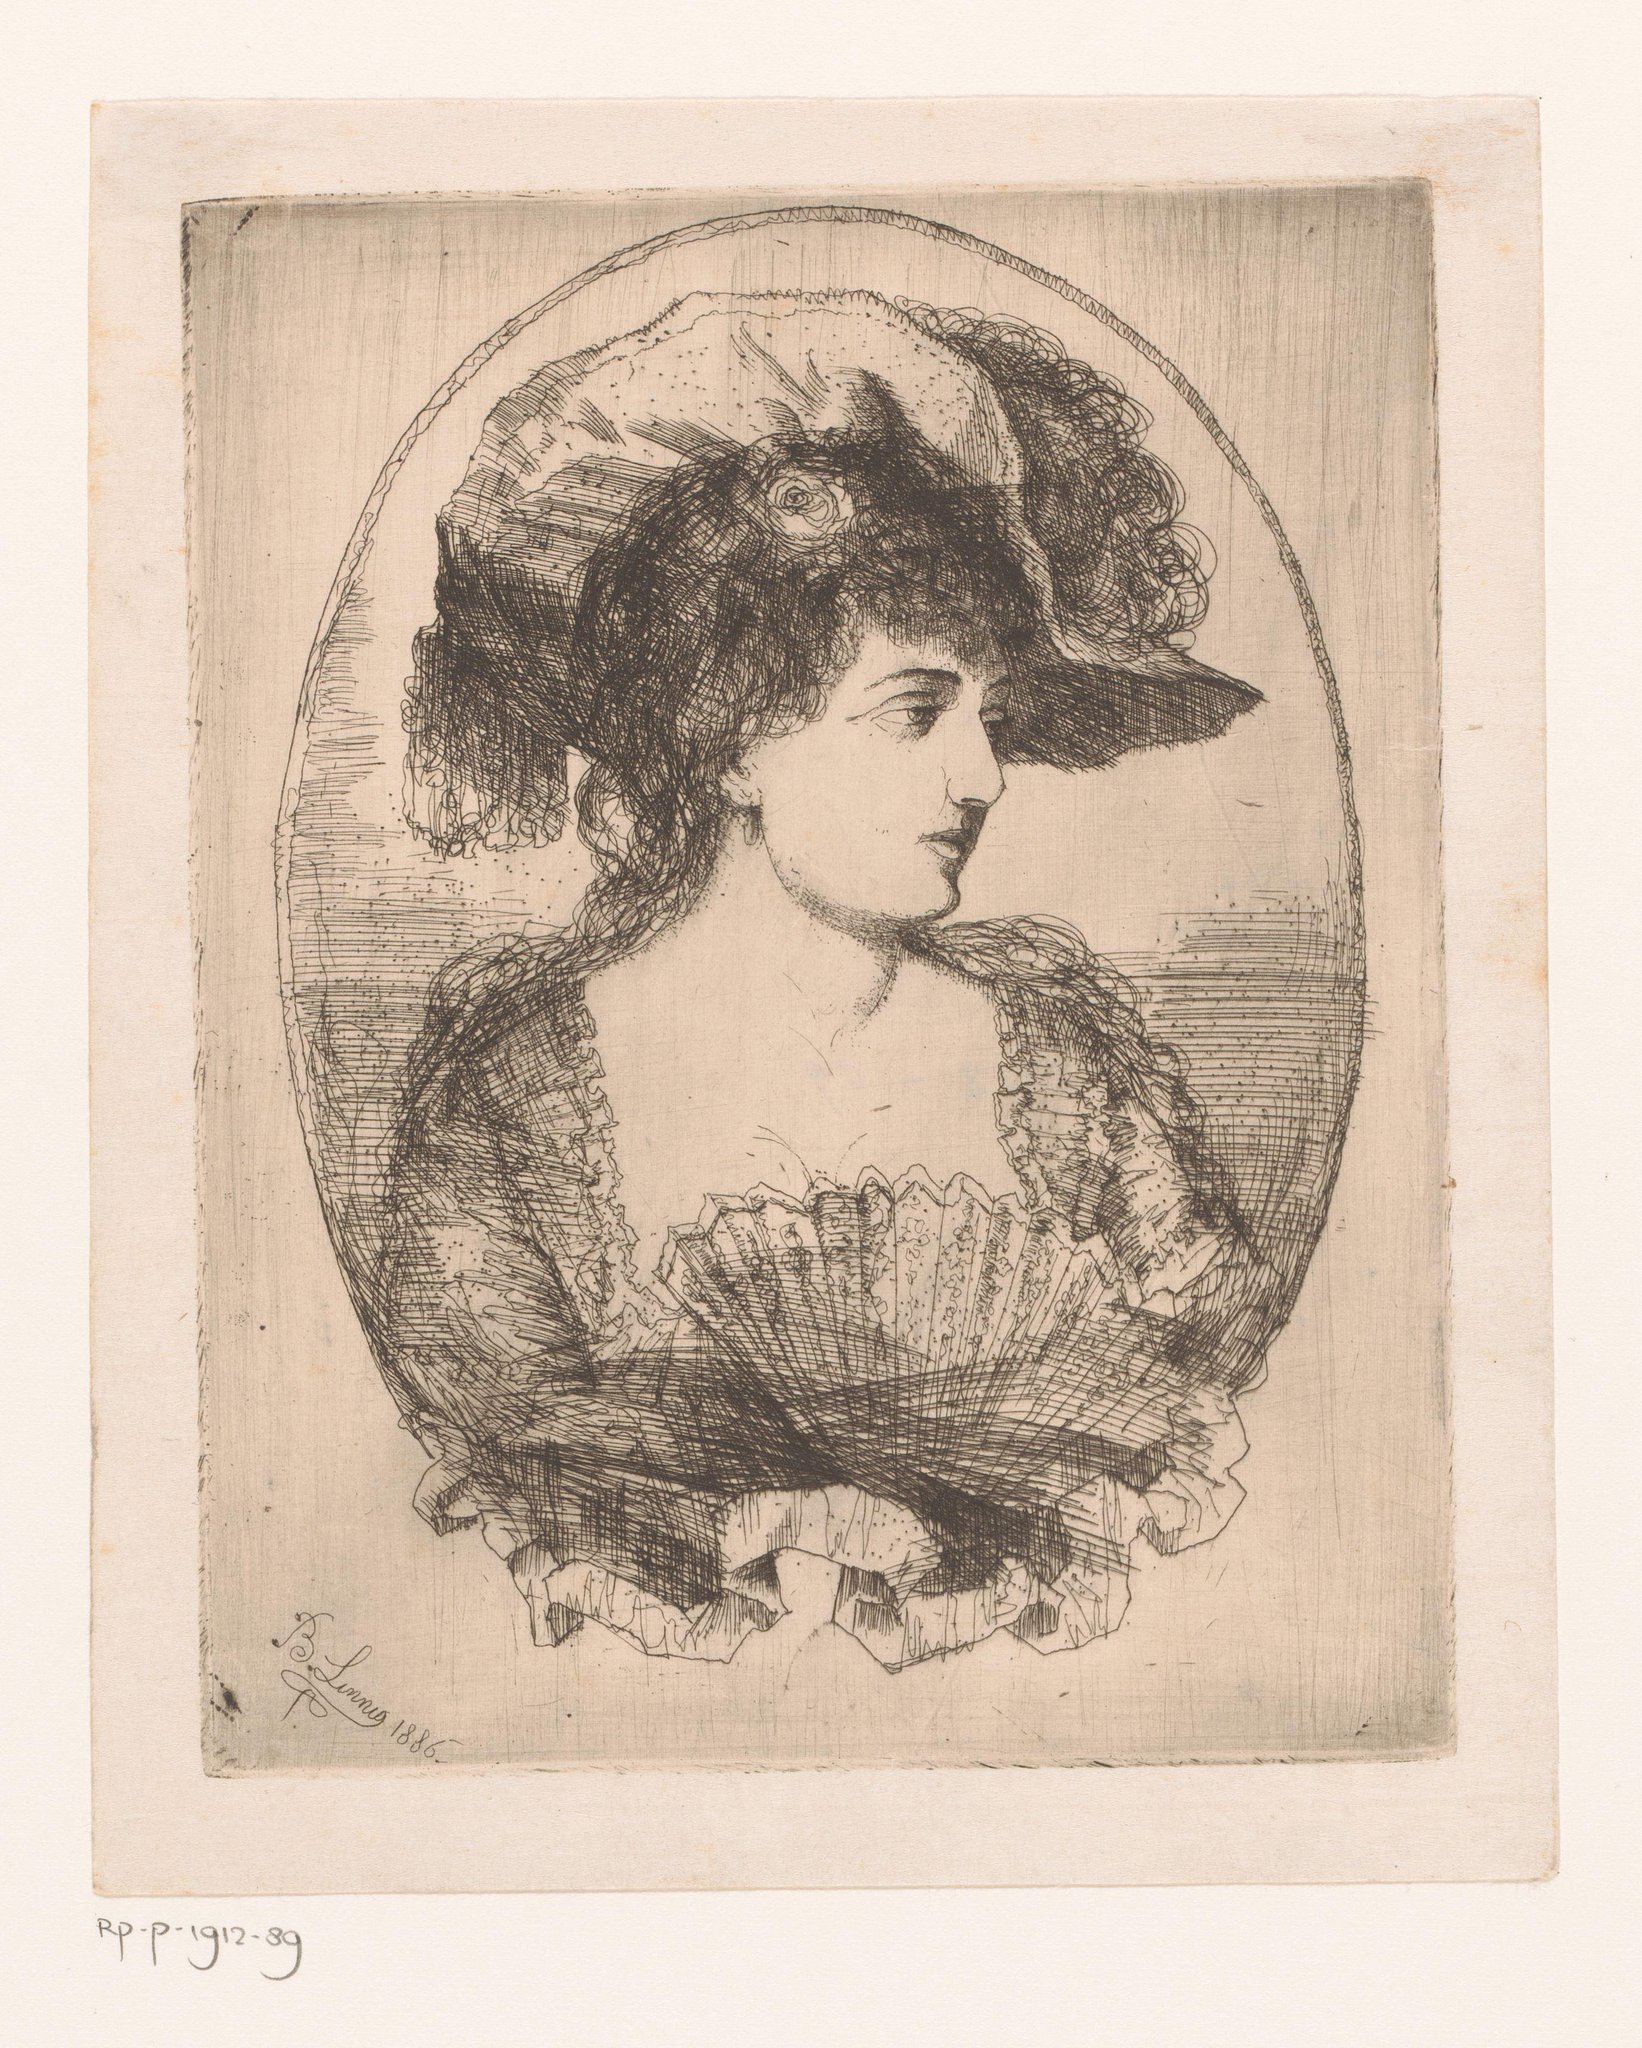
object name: print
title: Portret van een onbekende jonge vrouw met hoed en waaier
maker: ben linnig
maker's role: print maker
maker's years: 1860-1929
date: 1886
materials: paper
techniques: drypoint, etching, intaglio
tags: anonymous historical person portrayed alone - bb - woman, fan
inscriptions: collector's mark: Lugt 2228